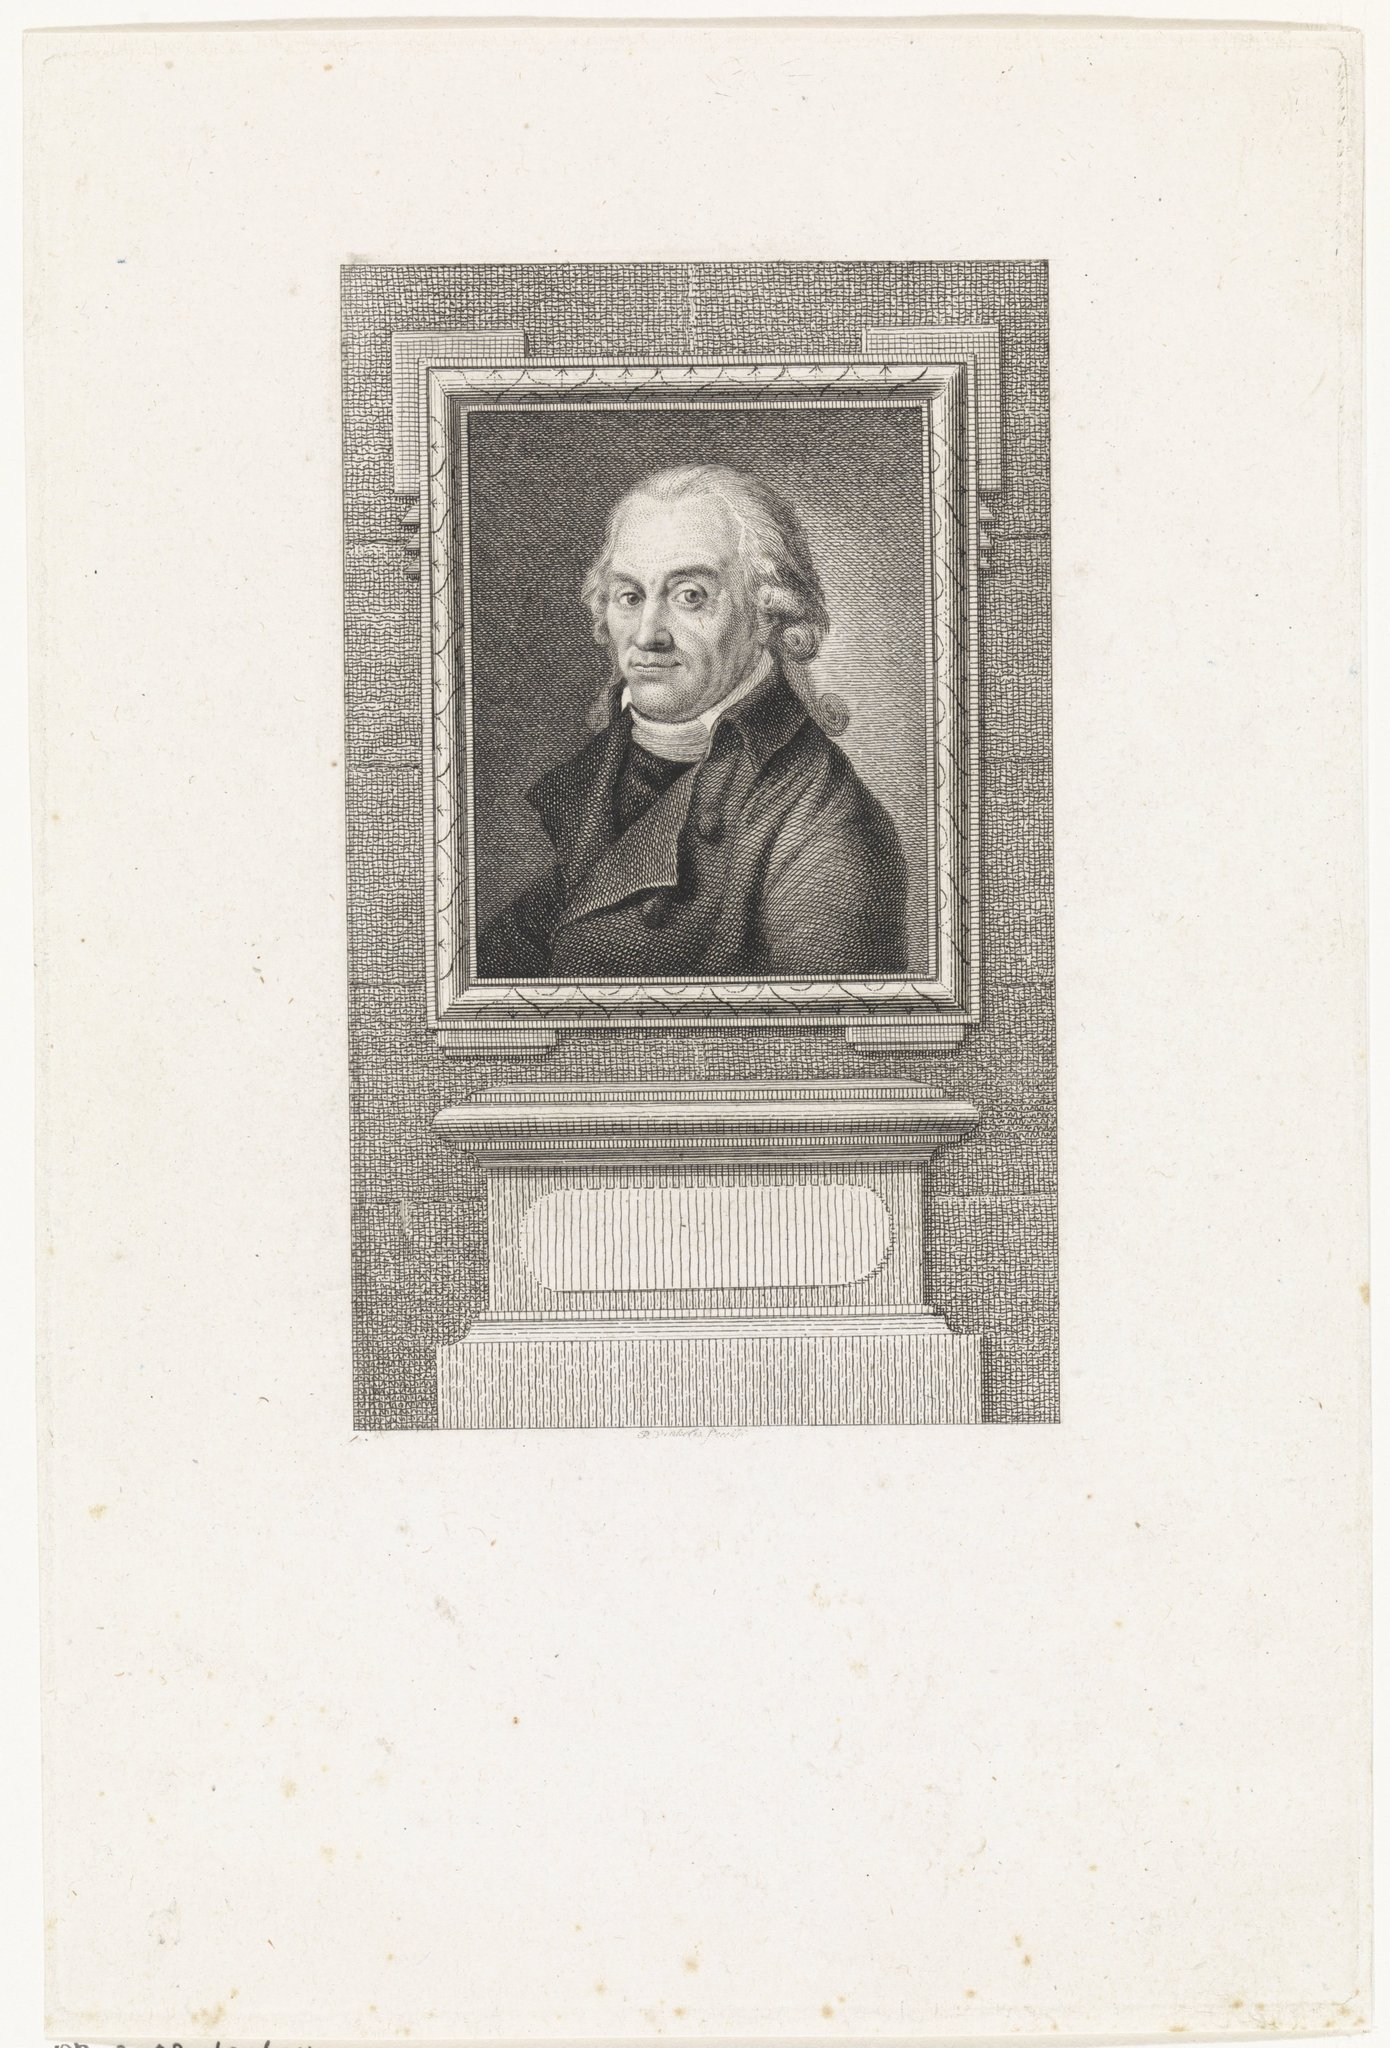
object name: print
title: Portret van Henri Daniel Guyot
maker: reinier vinkeles (i)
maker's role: draughtsman, print maker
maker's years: 1741-1816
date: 1786-1809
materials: paper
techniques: engraving, etching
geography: amsterdam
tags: france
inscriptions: collector's mark: Lugt 2228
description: Latere staat prent gebruikt als boekillustratie in: Wagenaar, Jan. Vaderlandsche historie, (...) ten vervolge van Wagenaars Vaderlandsche historie. Dl. 1-43. Amsterdam: Johannes Allart, 1786-1809.